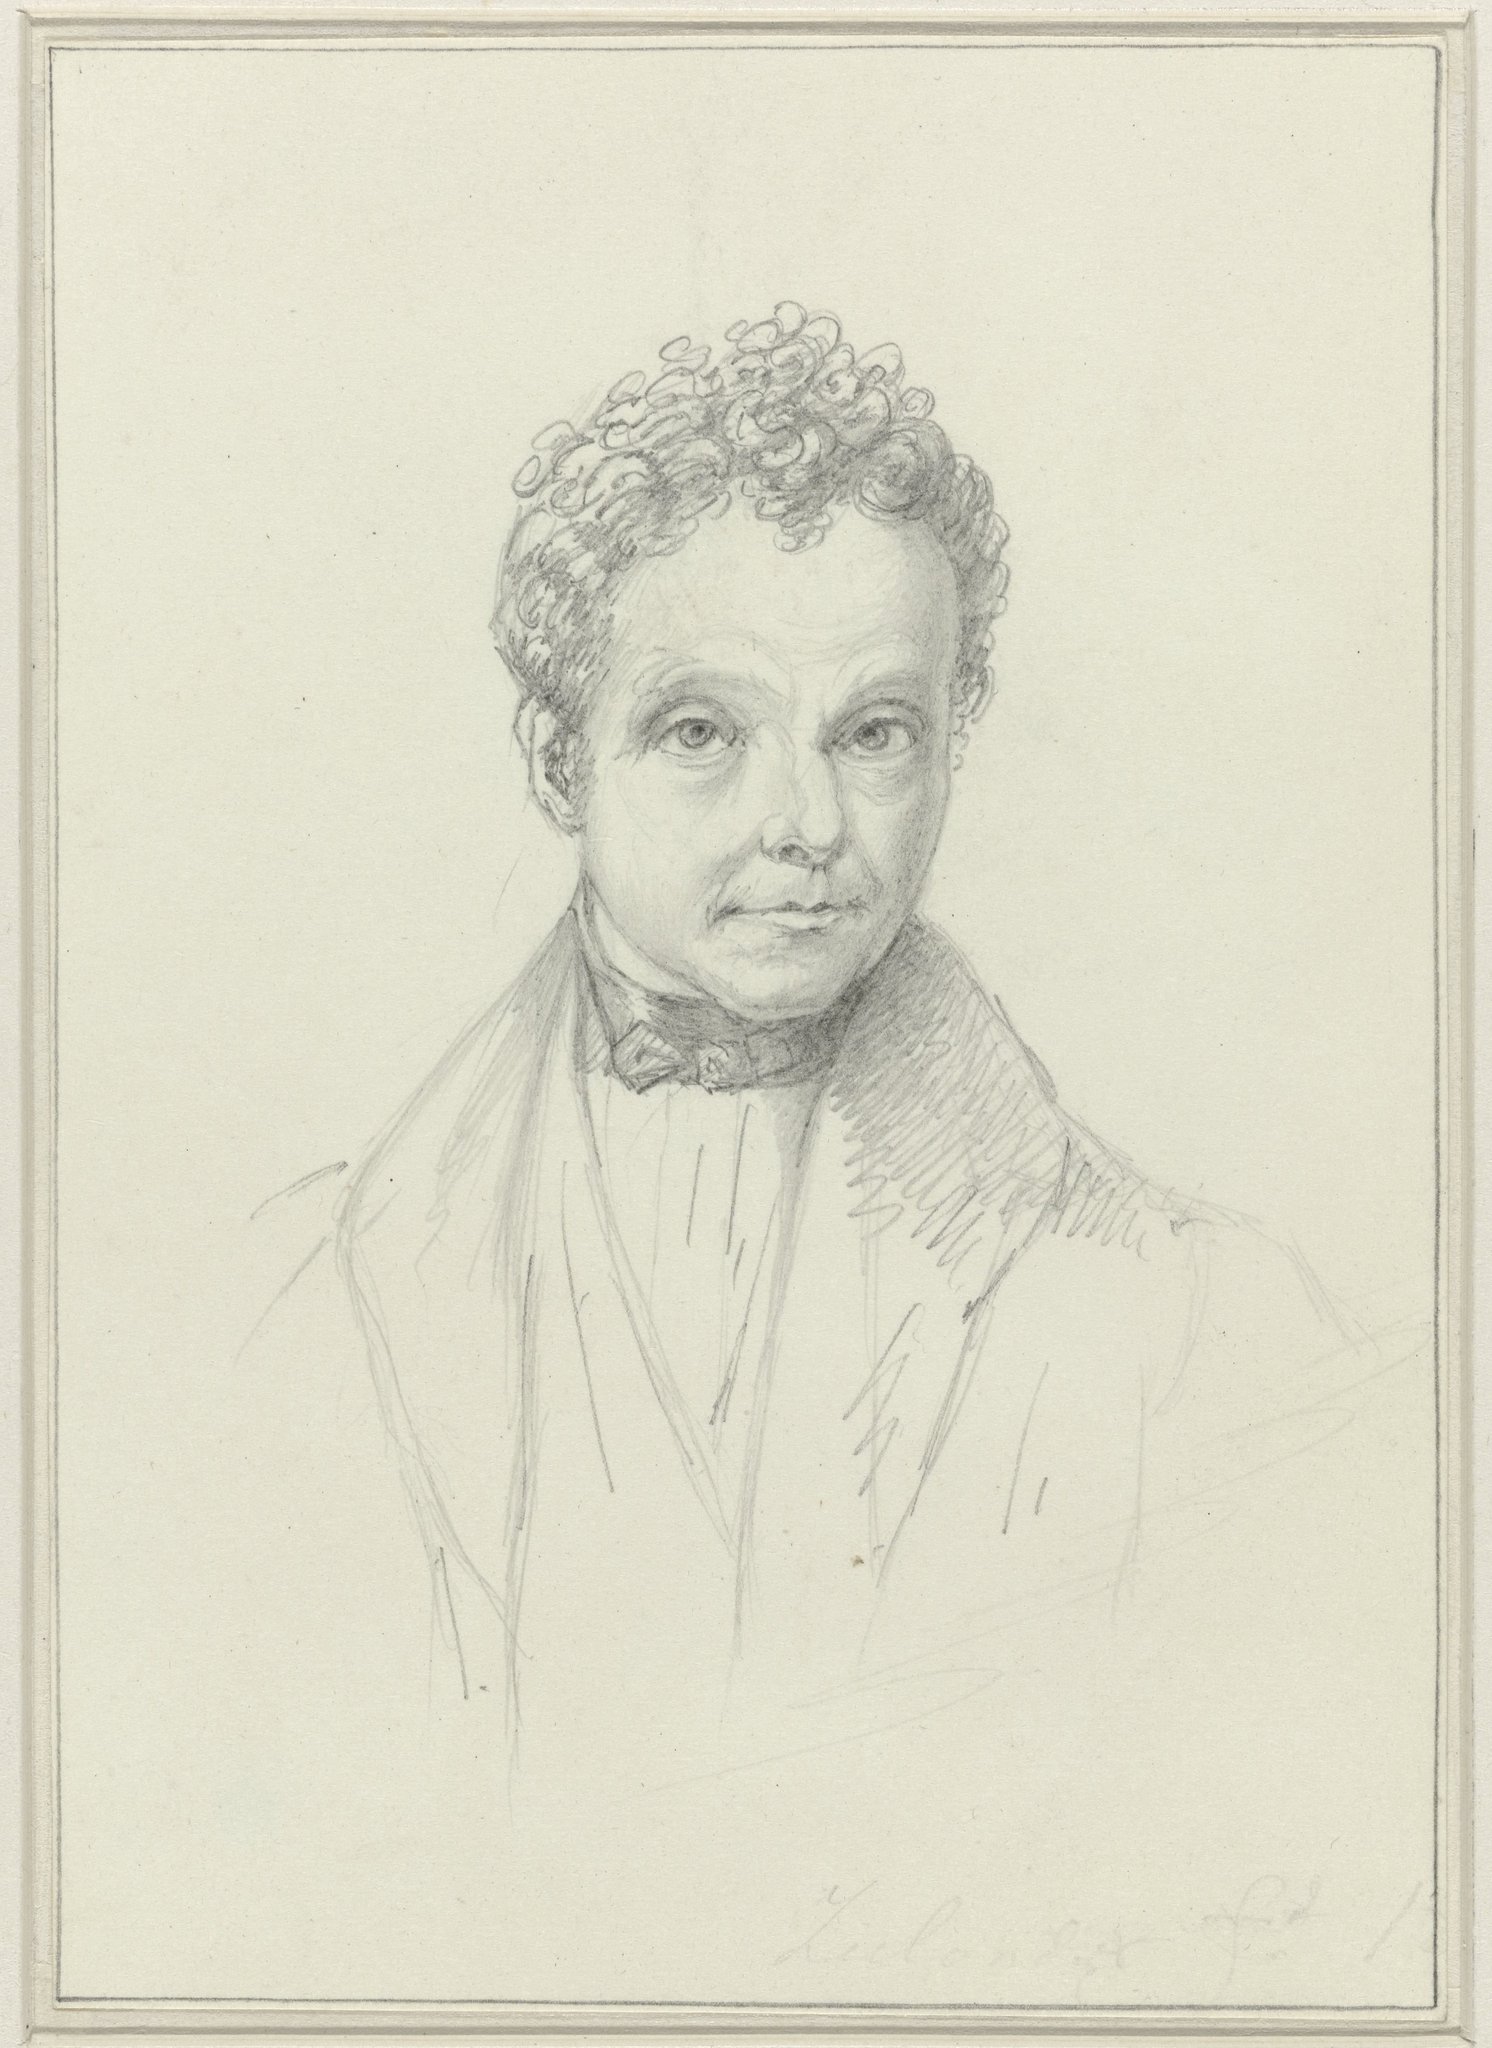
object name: drawing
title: Zelfportret van de Abraham Lion Zeelander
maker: abraham lion zeelander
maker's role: draughtsman, print maker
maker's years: 1789-1856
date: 1799-1856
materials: paper, pencil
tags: amsterdam, draughtsman, abraham lion zeelander, historical persons, portrait, self-portrait of artist, portrait, self-portrait of graphic artist, portrait, self-portrait of draughtsman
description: Zelfportret van de graveur en tekenaar Abraham Lion Zeelander.